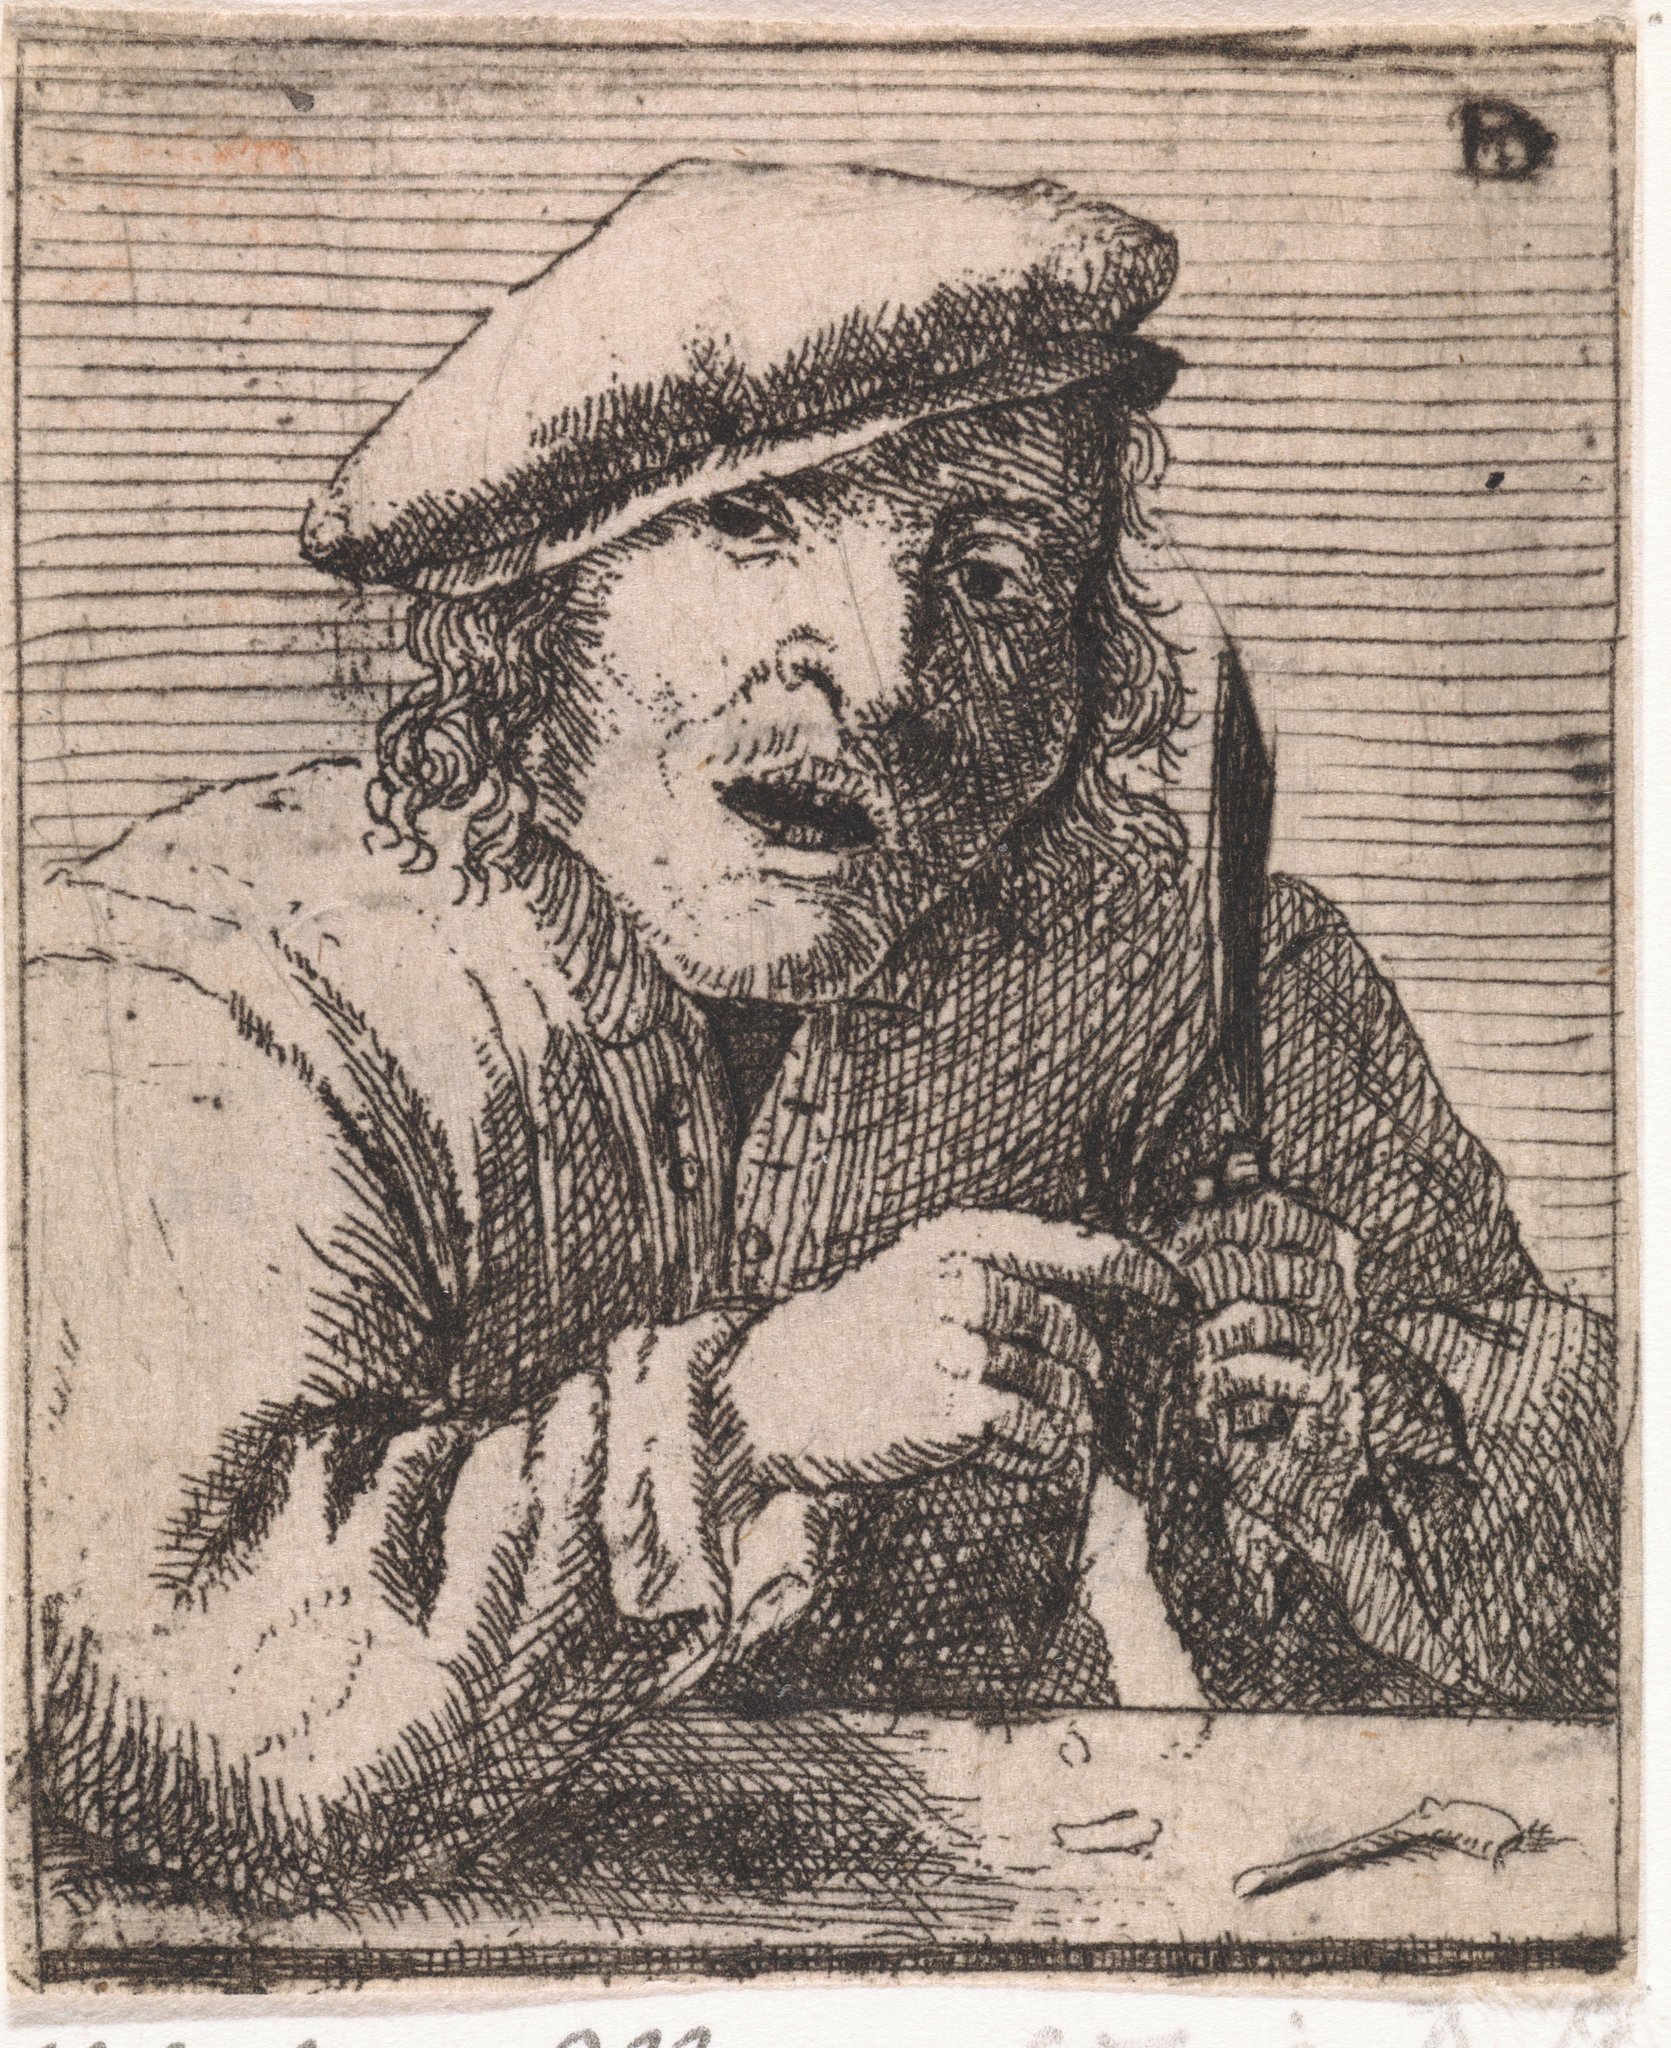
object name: print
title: De vijf zintuigen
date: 1626-1740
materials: paper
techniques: etching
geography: low countries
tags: feeling (one of the five senses)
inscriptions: collector's mark: Lugt 2228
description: Een man slaakt een kreet, omdat hij met een mes in zijn vinger heeft gesneden. Personificatie van het gevoel. Prent maakt deel uit van een serie van de vijf zintuigen.